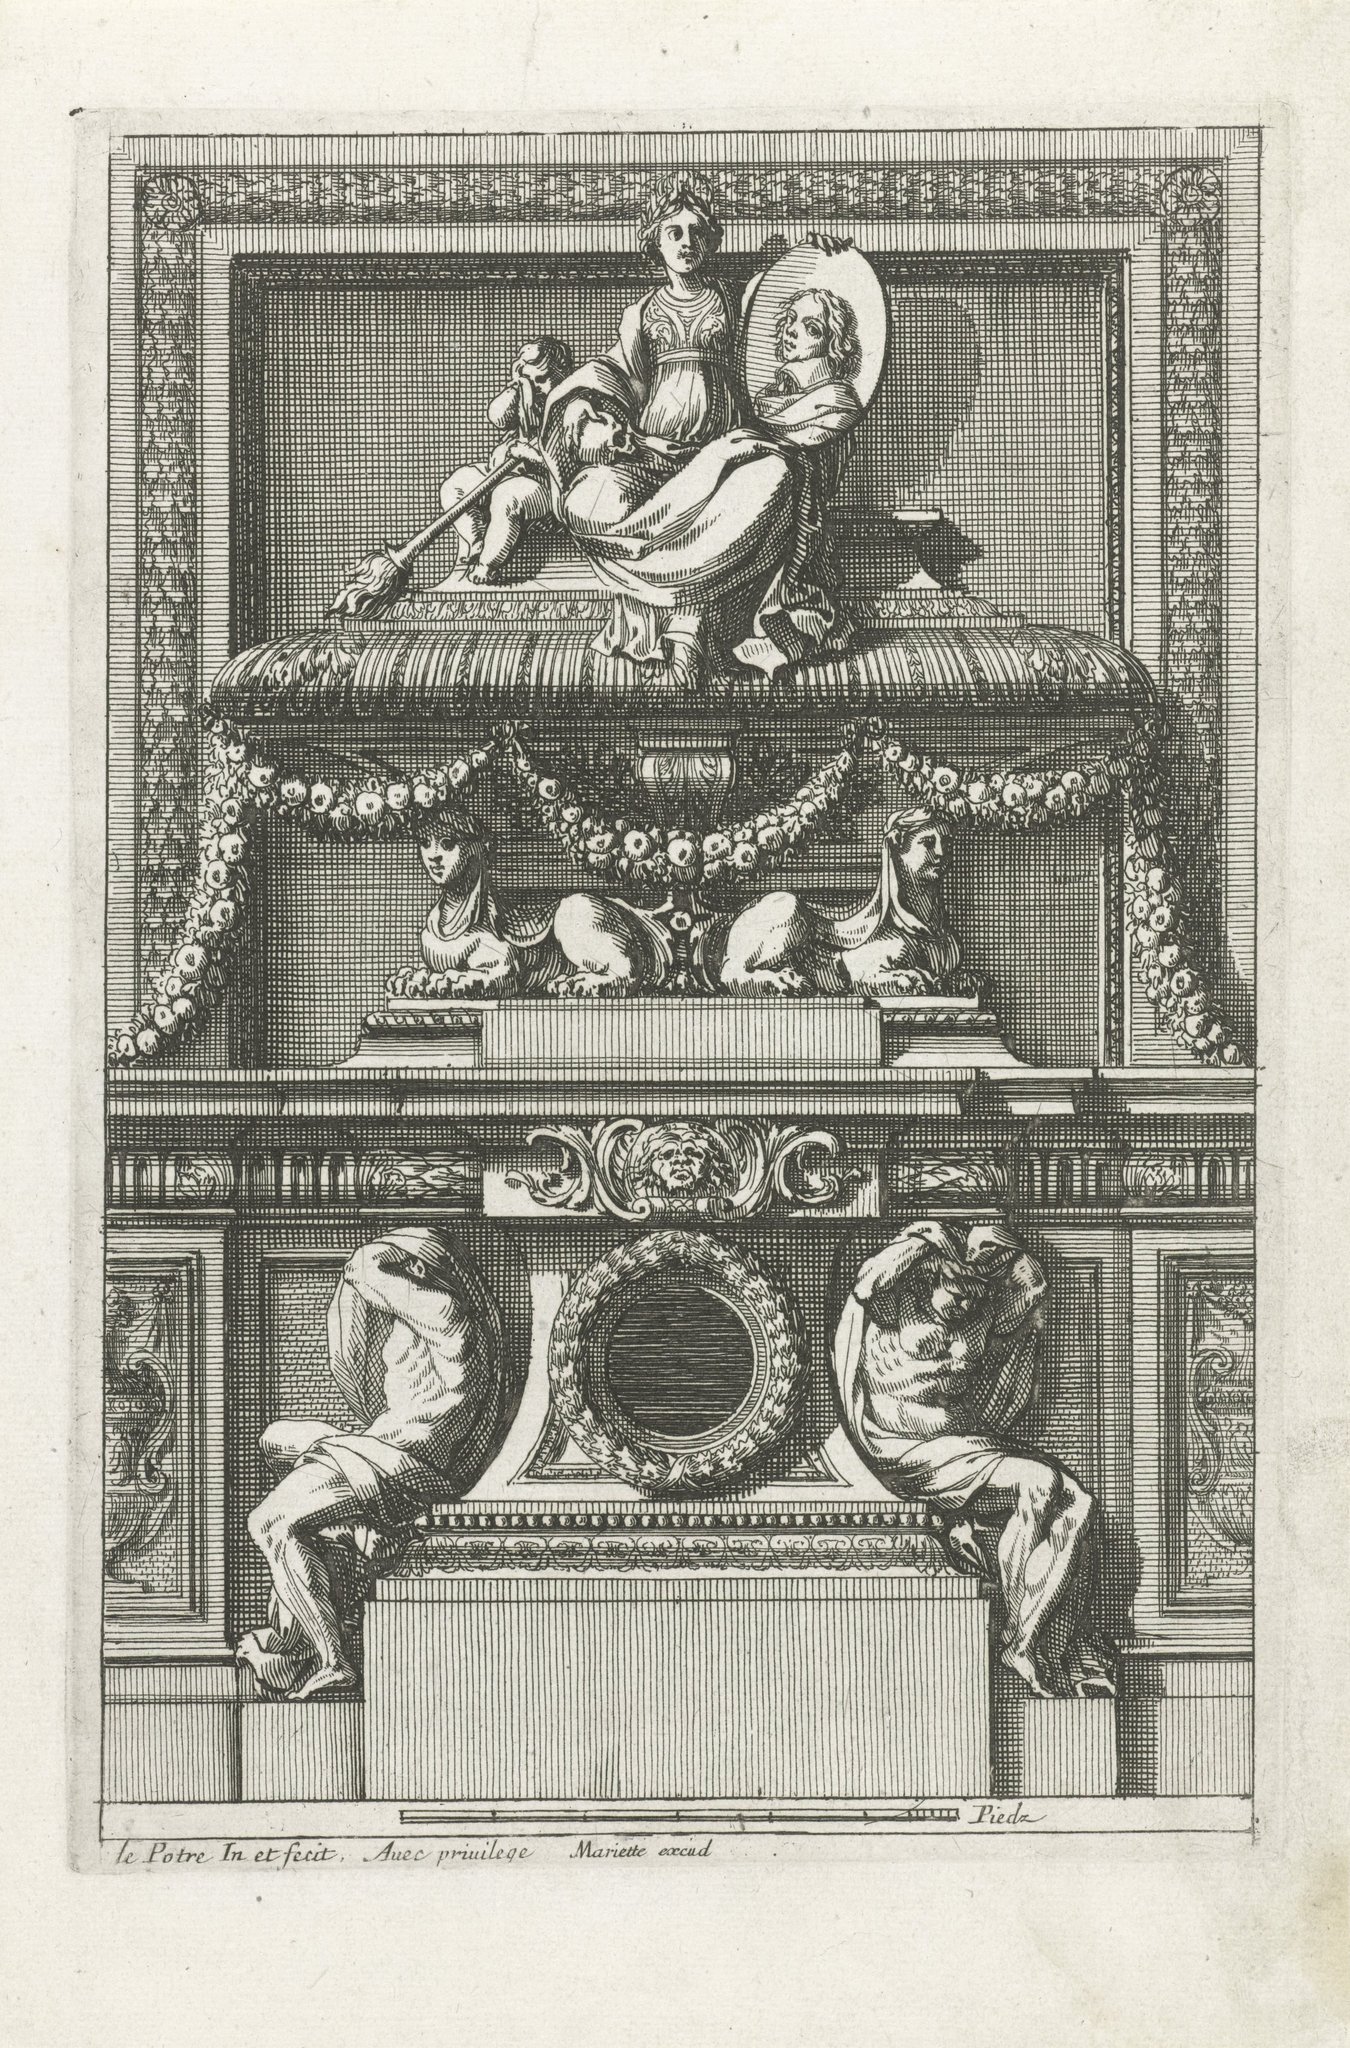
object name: ornament print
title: Grafmonument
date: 1661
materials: paper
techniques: etching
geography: france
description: Het grafmonument staat tegen een muur, twee sfinxen ondersteunen de kist waarop een vrouw zit met een schedel en een ovaal portret van een man in haar handen. Blad 2 uit serie van titelblad en 5 bladen, derde editie.